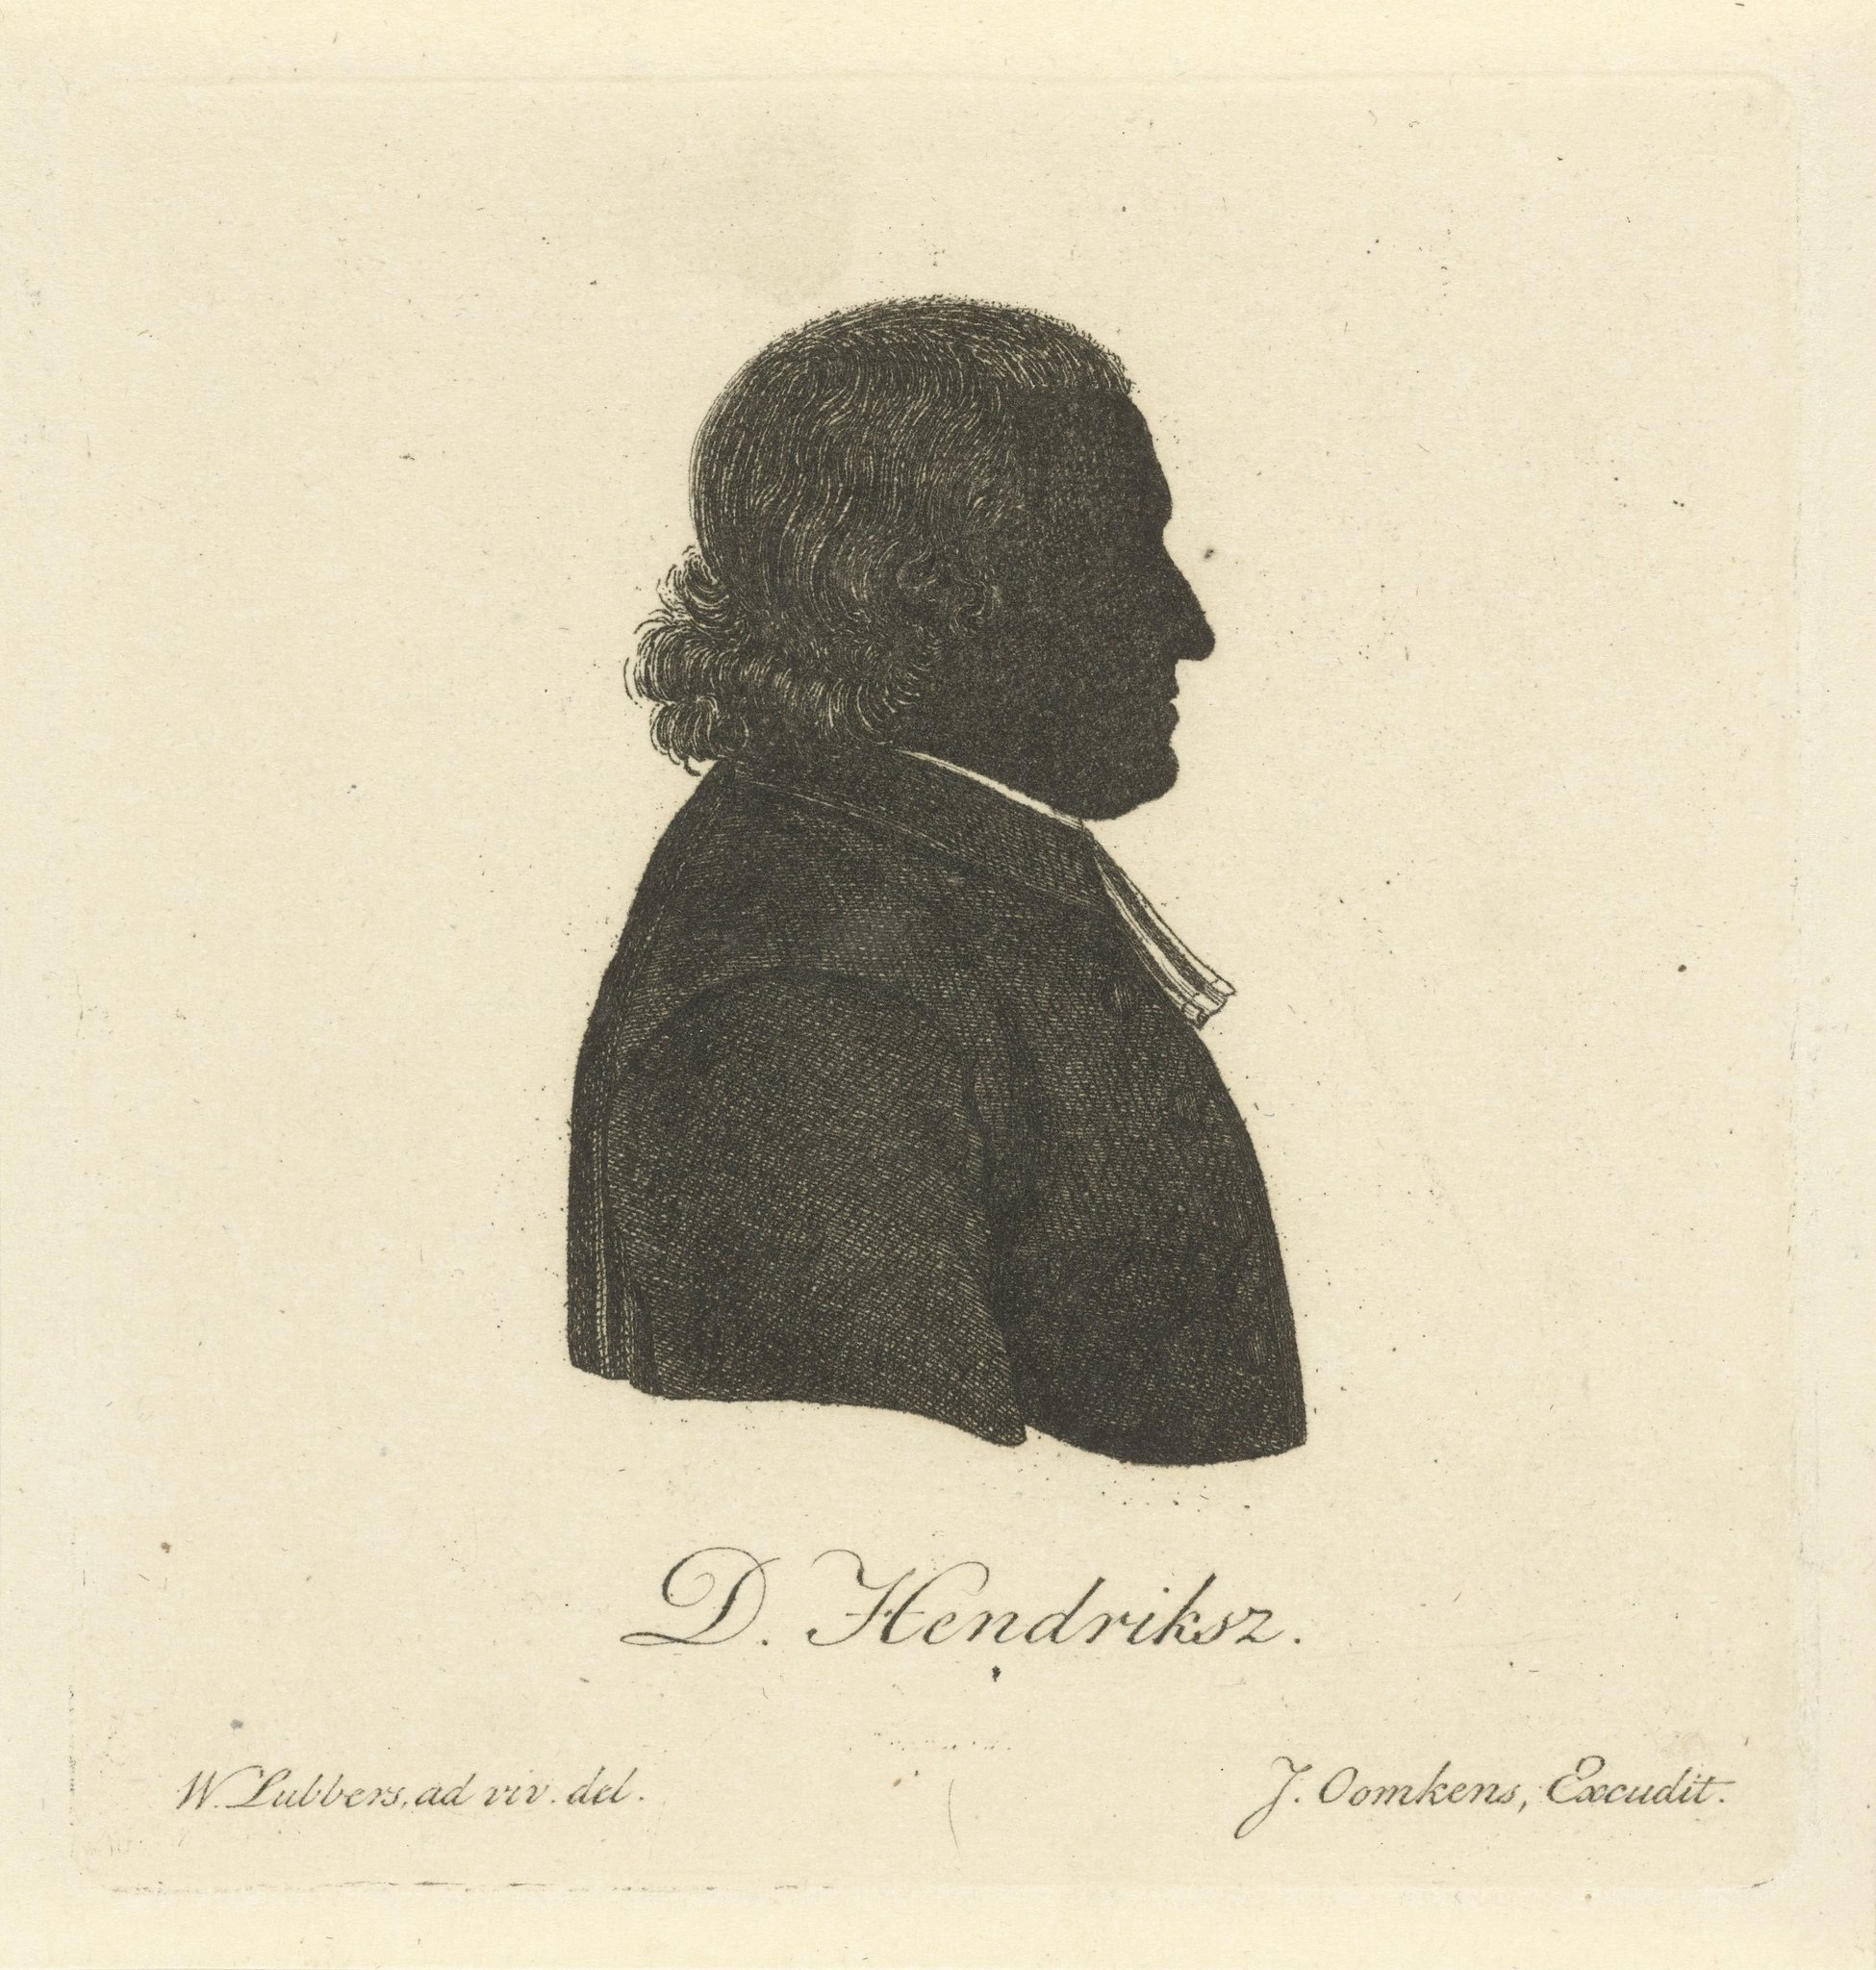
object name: print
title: Silhouetportret van Daniël Hendriksz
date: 1808-1844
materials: paper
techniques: etching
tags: groningen, predikant, daniël hendriksz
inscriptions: collector's mark: Lugt 2228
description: Silhouetportret van Daniël Hendriksz, buste naar rechts.